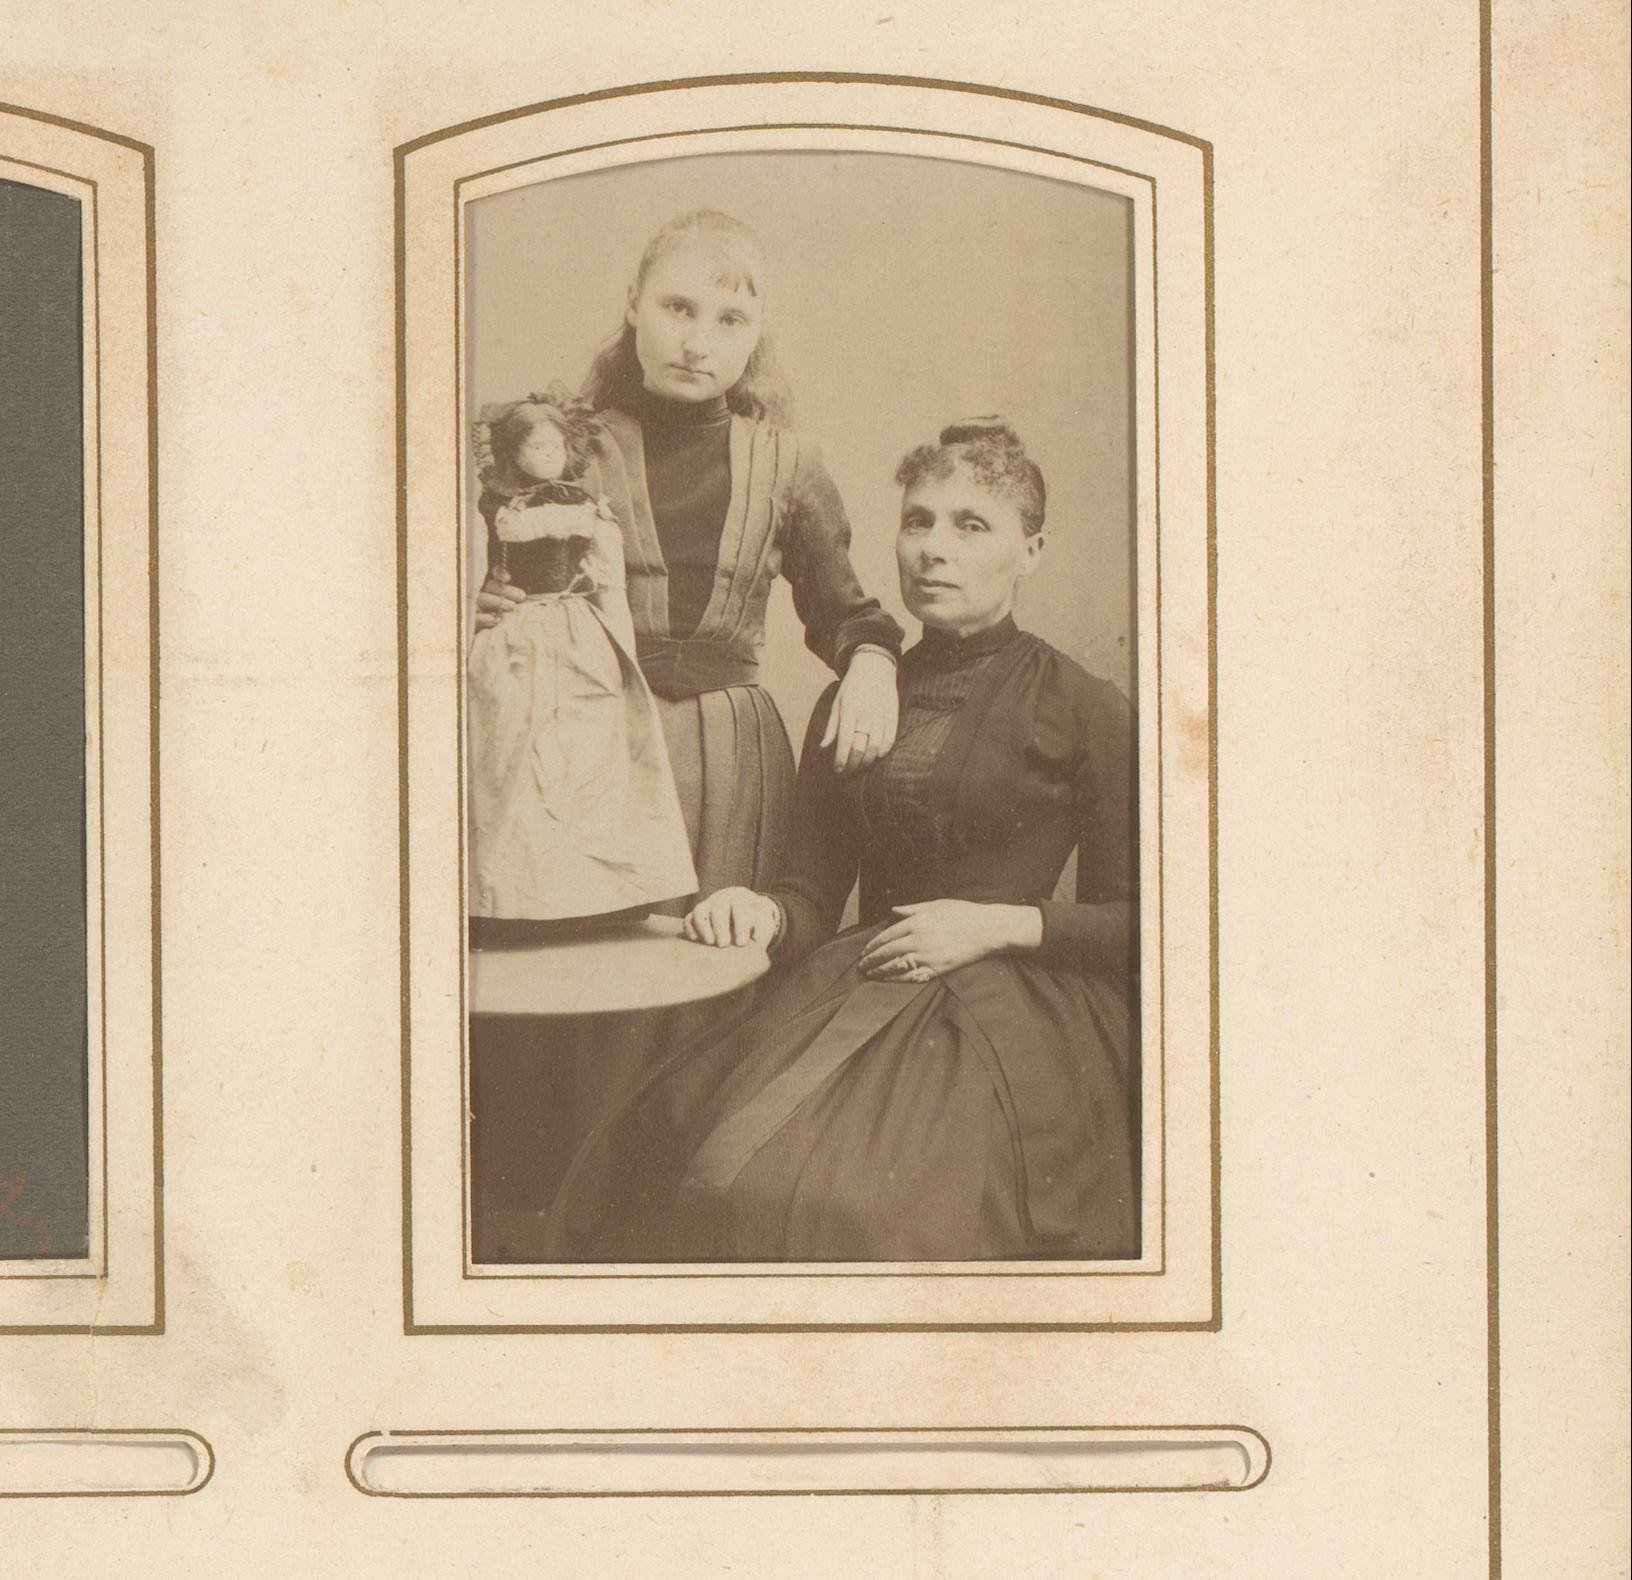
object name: photograph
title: Portret van een vrouw, een meisje en een pop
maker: Anonymous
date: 1860-1875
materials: cardboard, paper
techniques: albumen print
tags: historical persons - bb - woman, (playing with) dolls, mother and daughter(s) (family group)